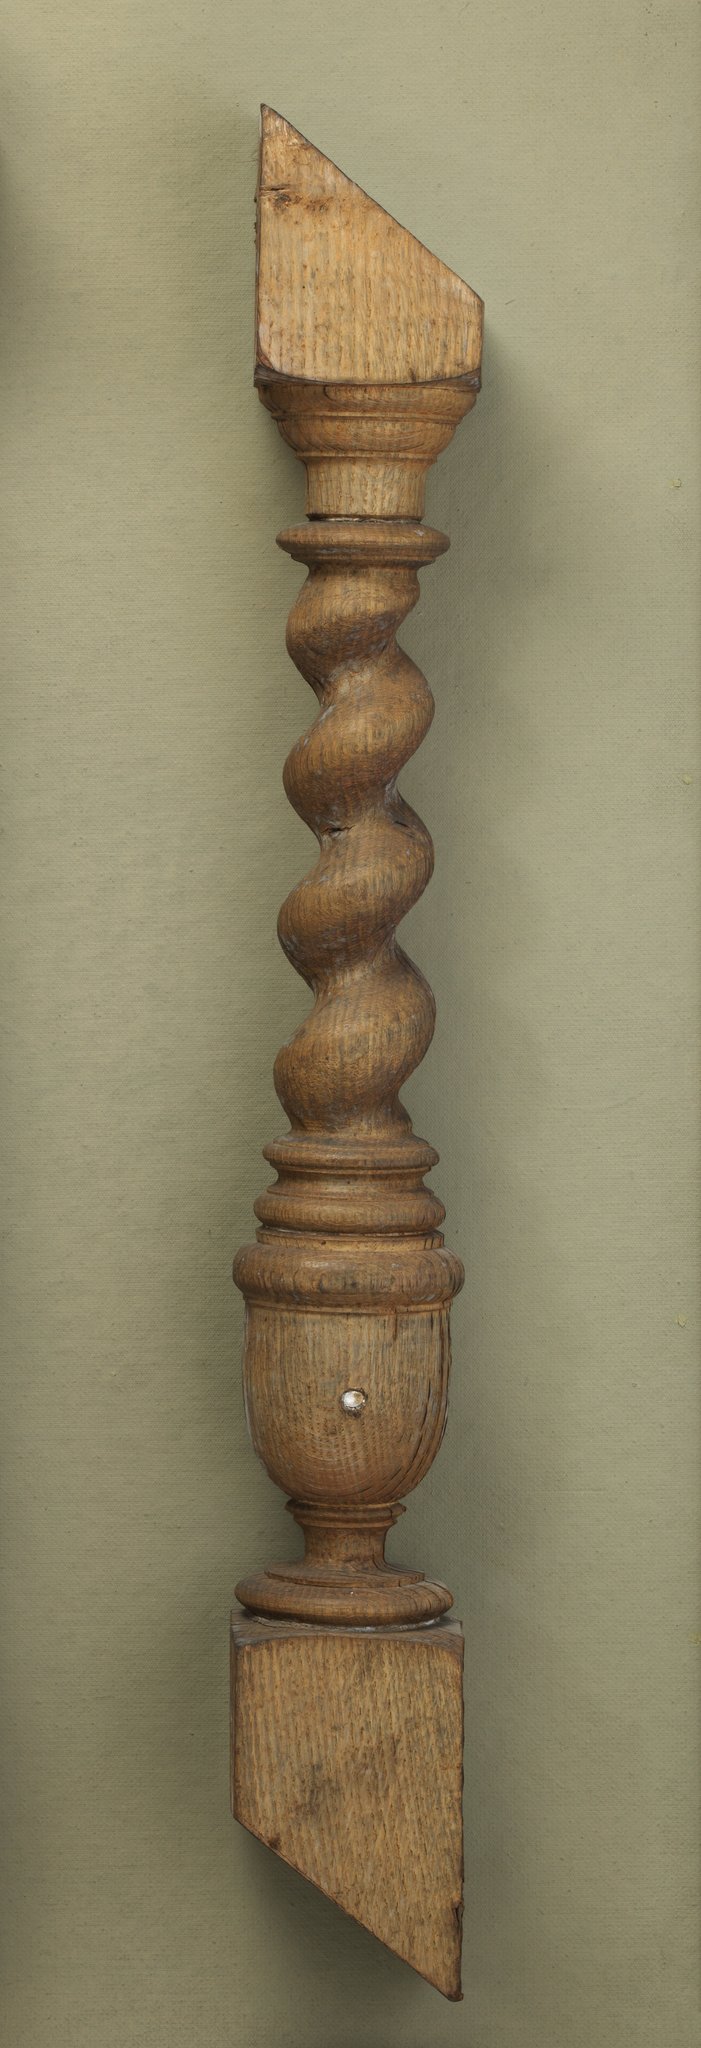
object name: baluster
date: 1651-1700